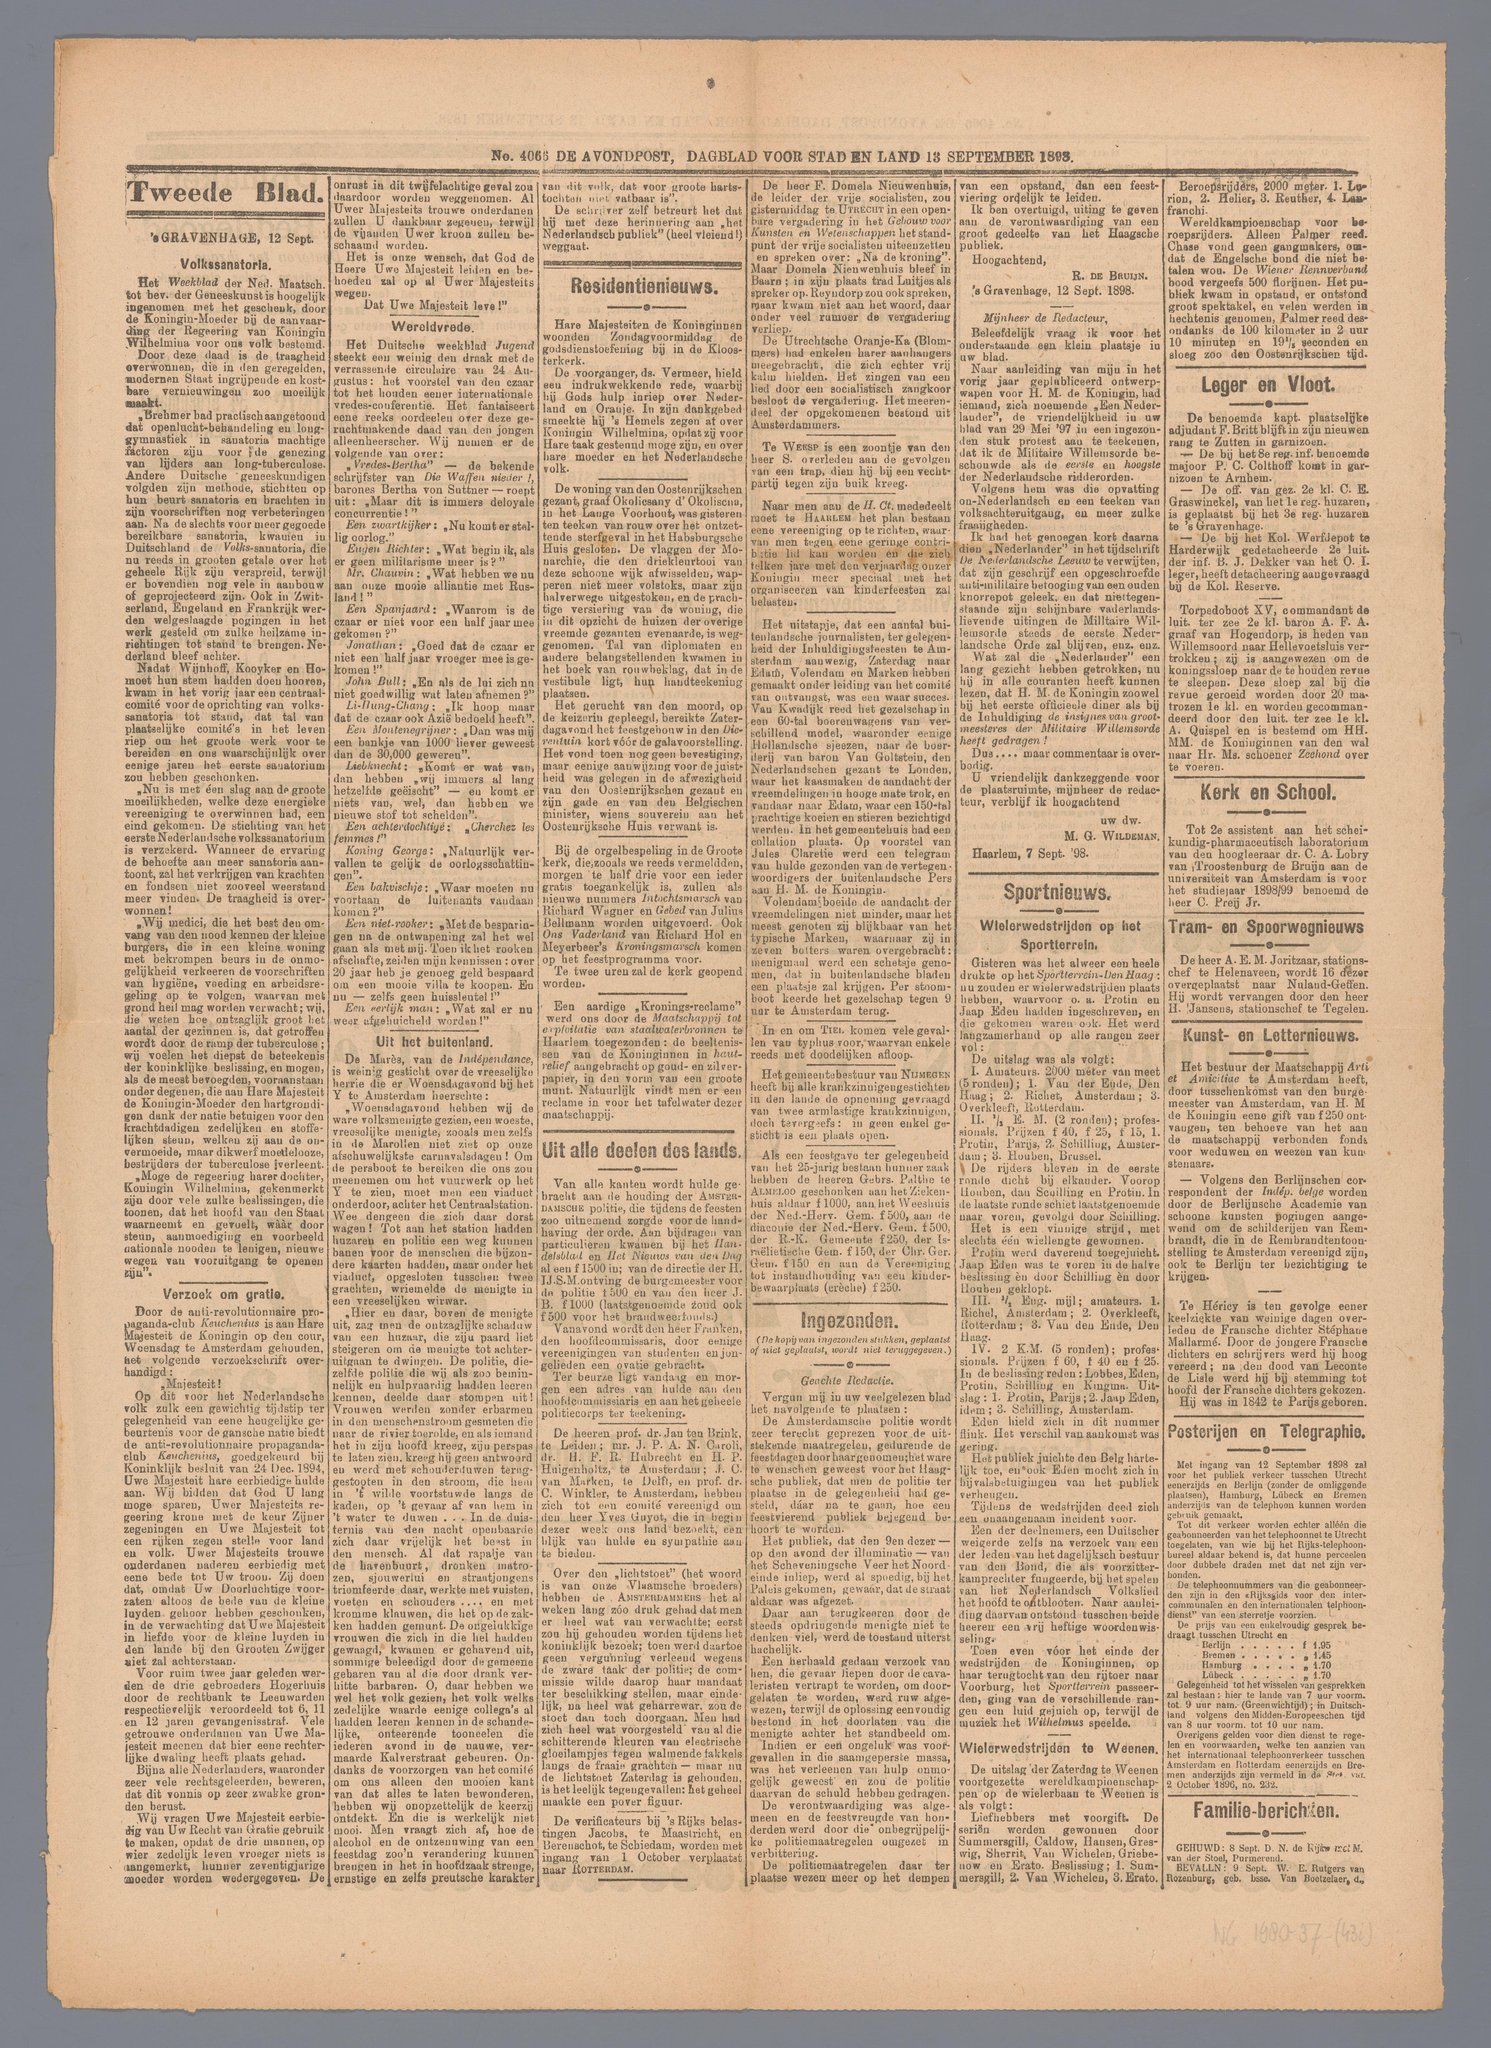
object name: newspaper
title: de Avondpost; dagblad voor stad en land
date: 1898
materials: paper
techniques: printing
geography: the hague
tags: print maker, wilhelmina of the netherlands, netherlands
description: Eén van een serie kranten, nrs. 4056 t/m 4073, van "de Avondpost" met berichten over de inhuldiging van koningin Wilhelmina 1898.